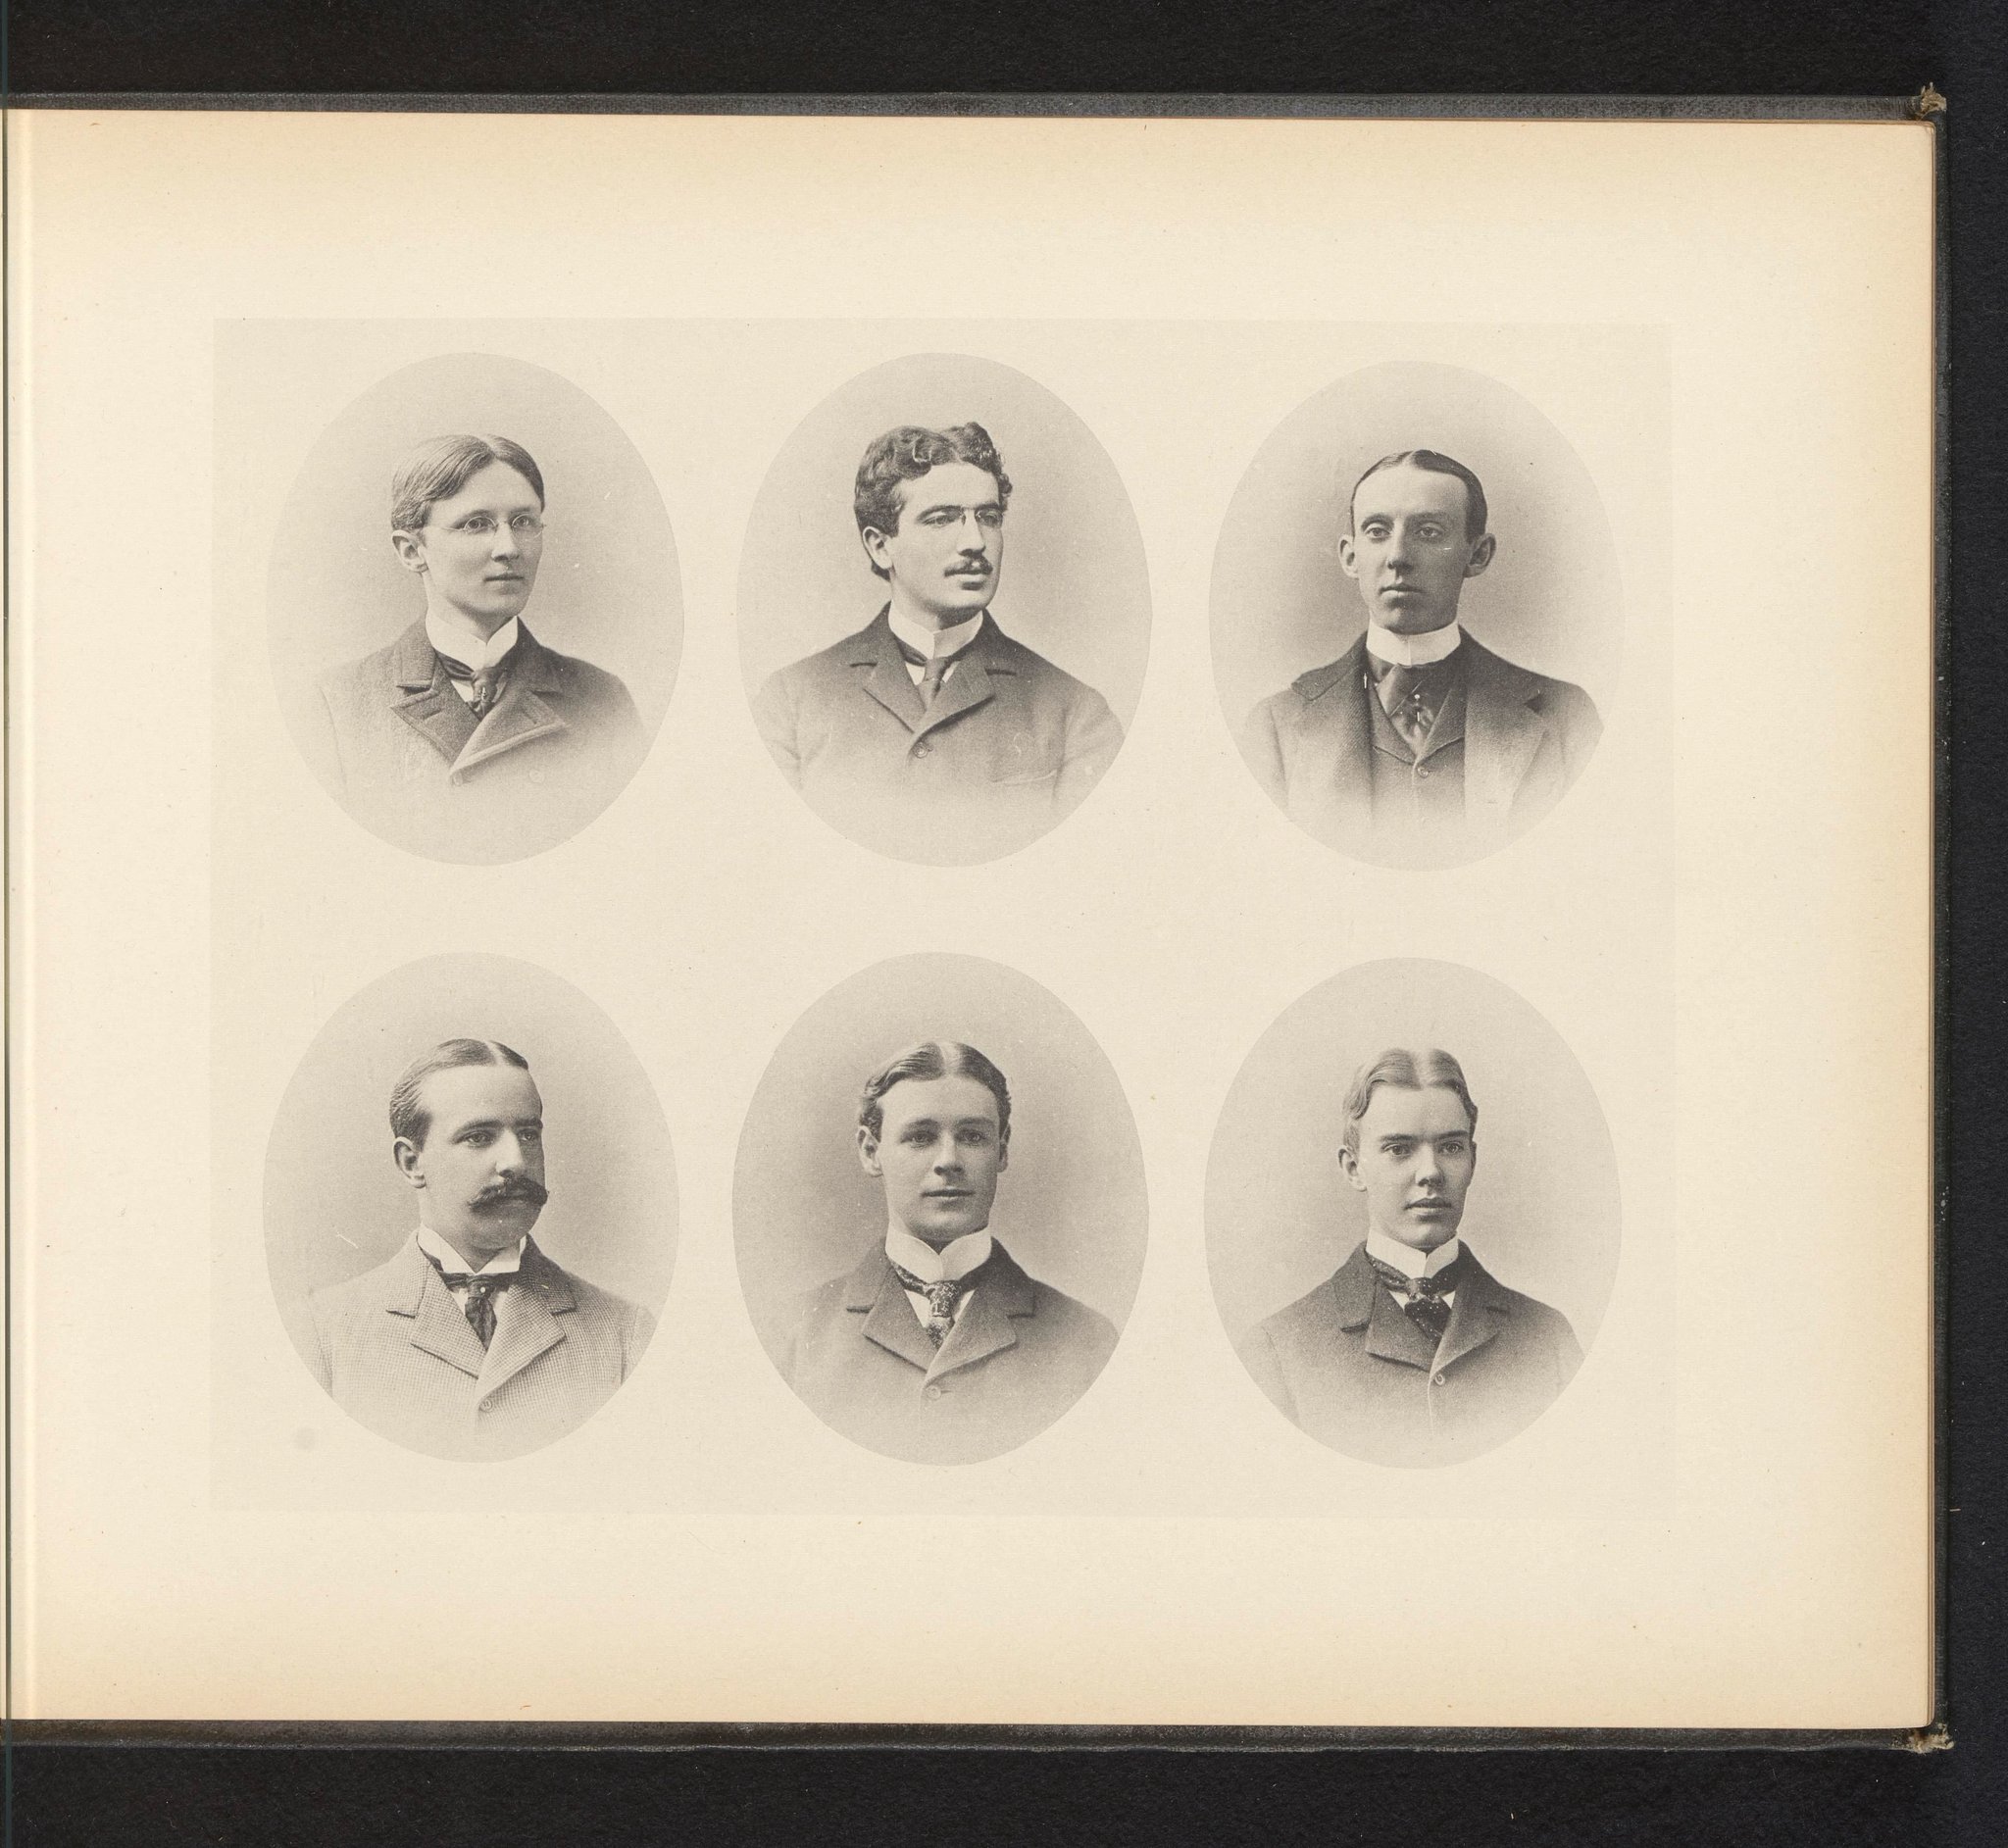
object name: photomechanical print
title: Zes portretten van afgestudeerde studenten van Yale University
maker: Anonymous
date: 1895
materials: paper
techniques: photograph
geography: new york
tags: student